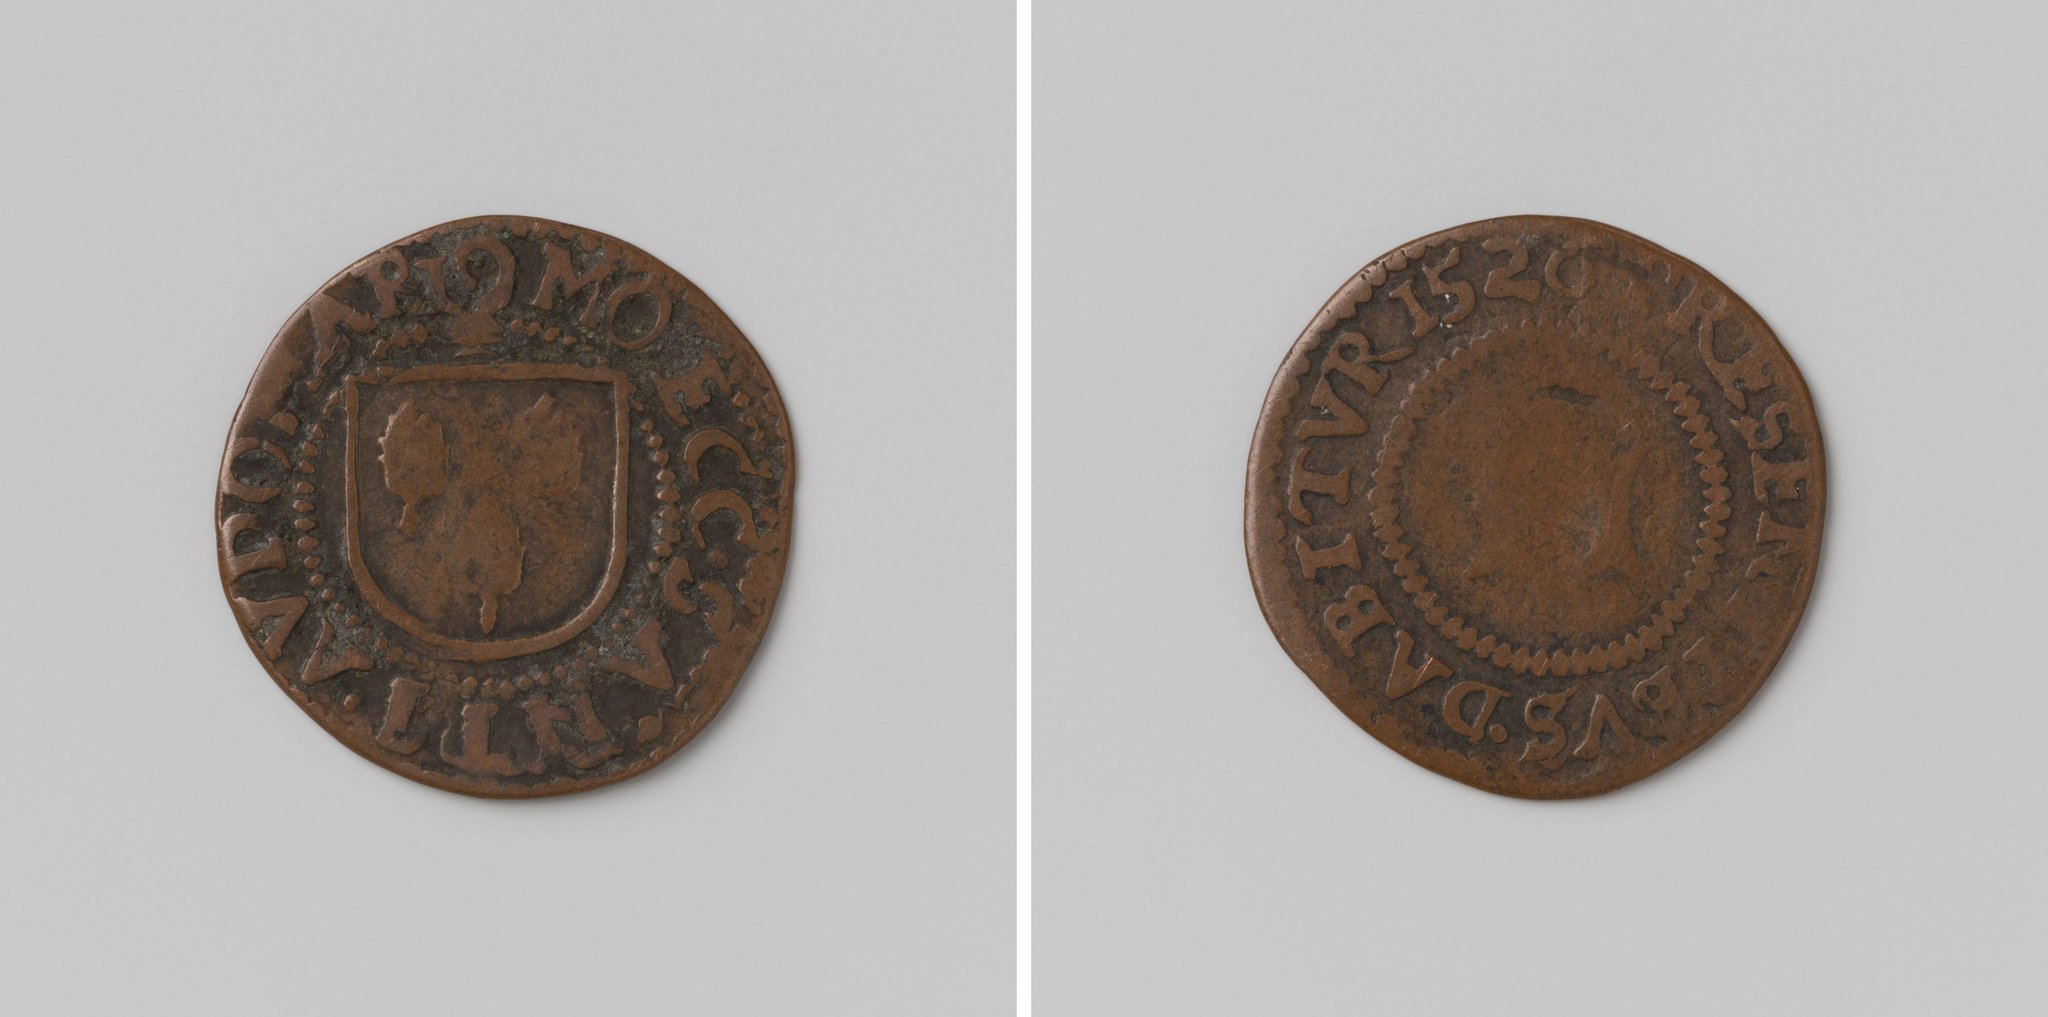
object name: devotional medal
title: Kerk van St. Omer, avondmaalspenning met no. 2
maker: Anonymous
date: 1526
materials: copper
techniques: striking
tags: saint-omer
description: Koperen penning. Voorzijde: wapenschild op bisschopsstaf binnen omschrift. Keerzijde: Romeins cijfer II binnen omschrift